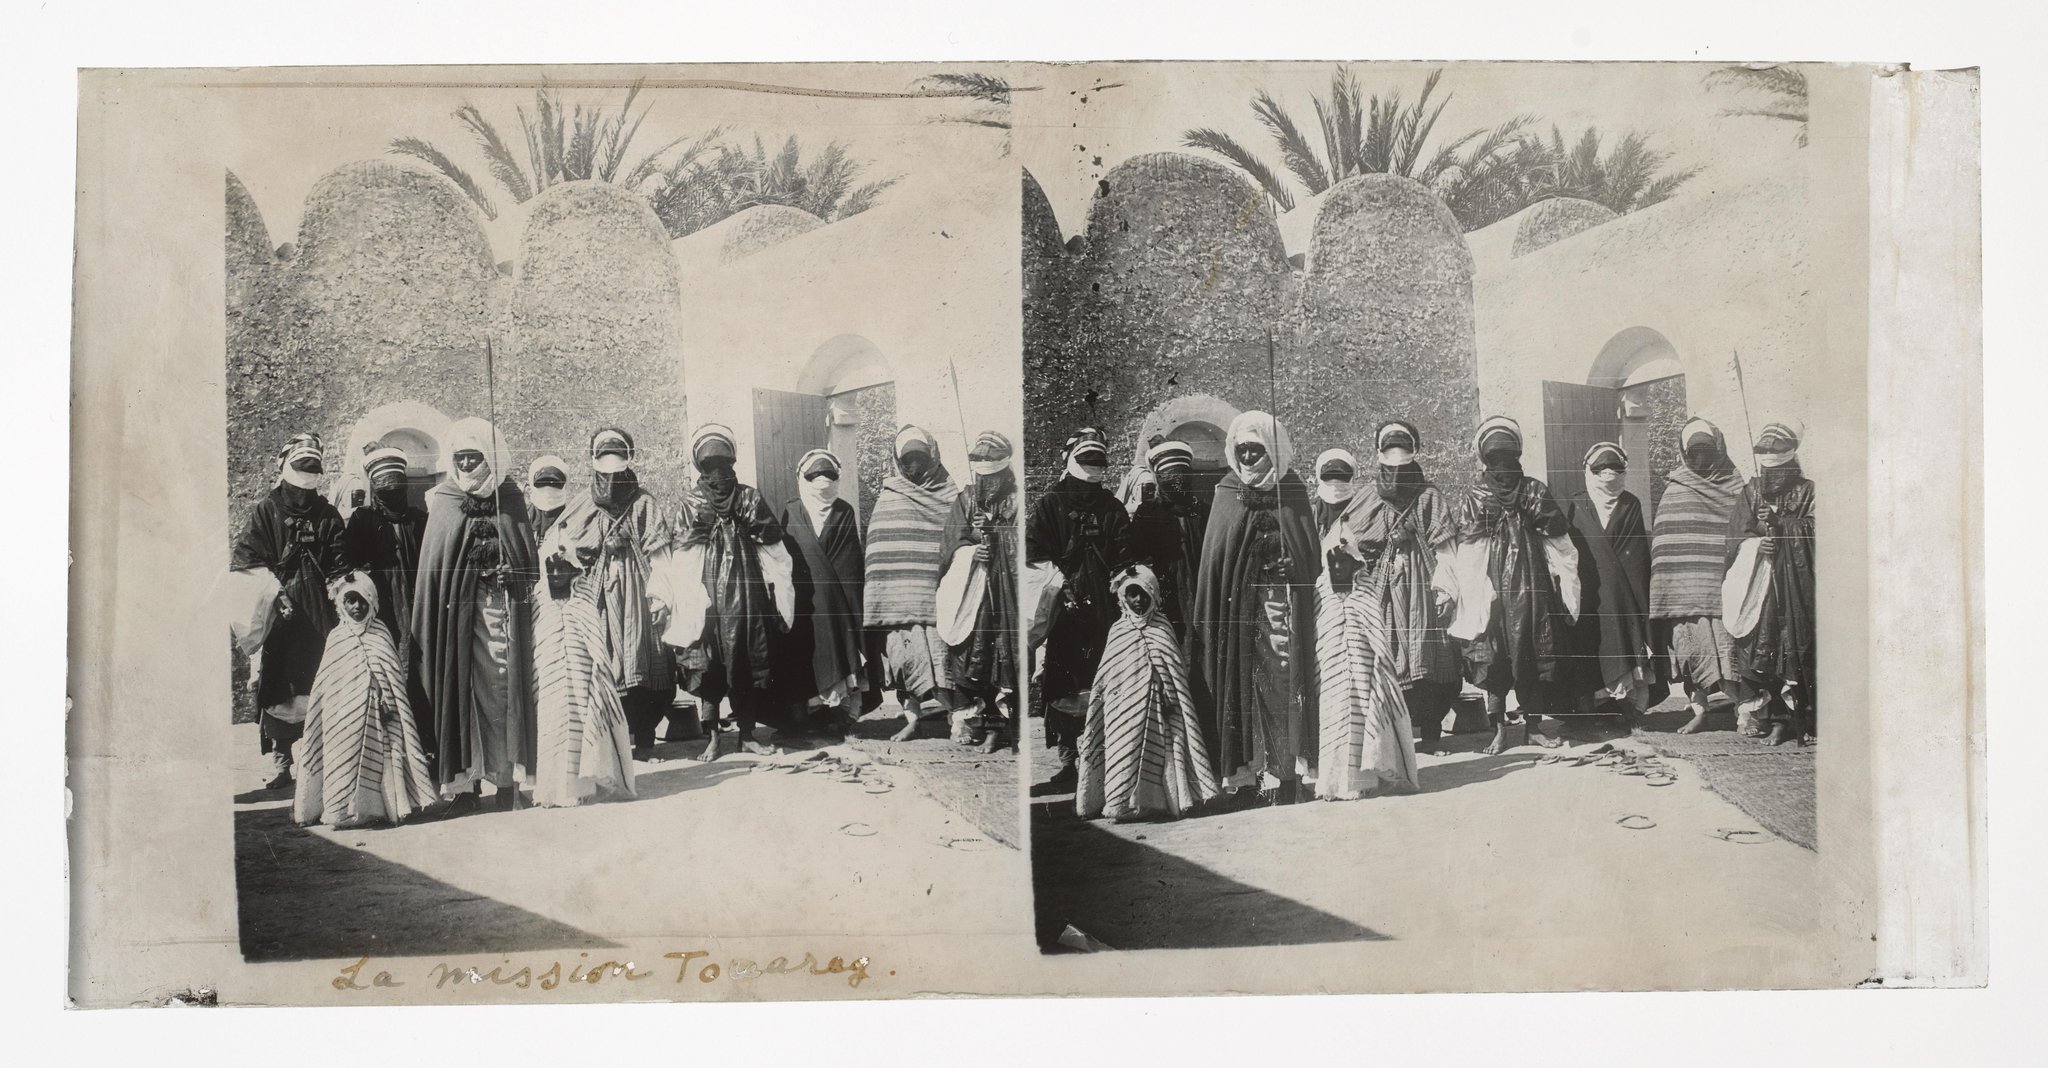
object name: stereoscopic photograph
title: La mission Touarag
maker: Anonymous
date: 1810-1890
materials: glass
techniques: slide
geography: north africa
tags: anonymous historical persons portrayed in a group, in a group-portrait